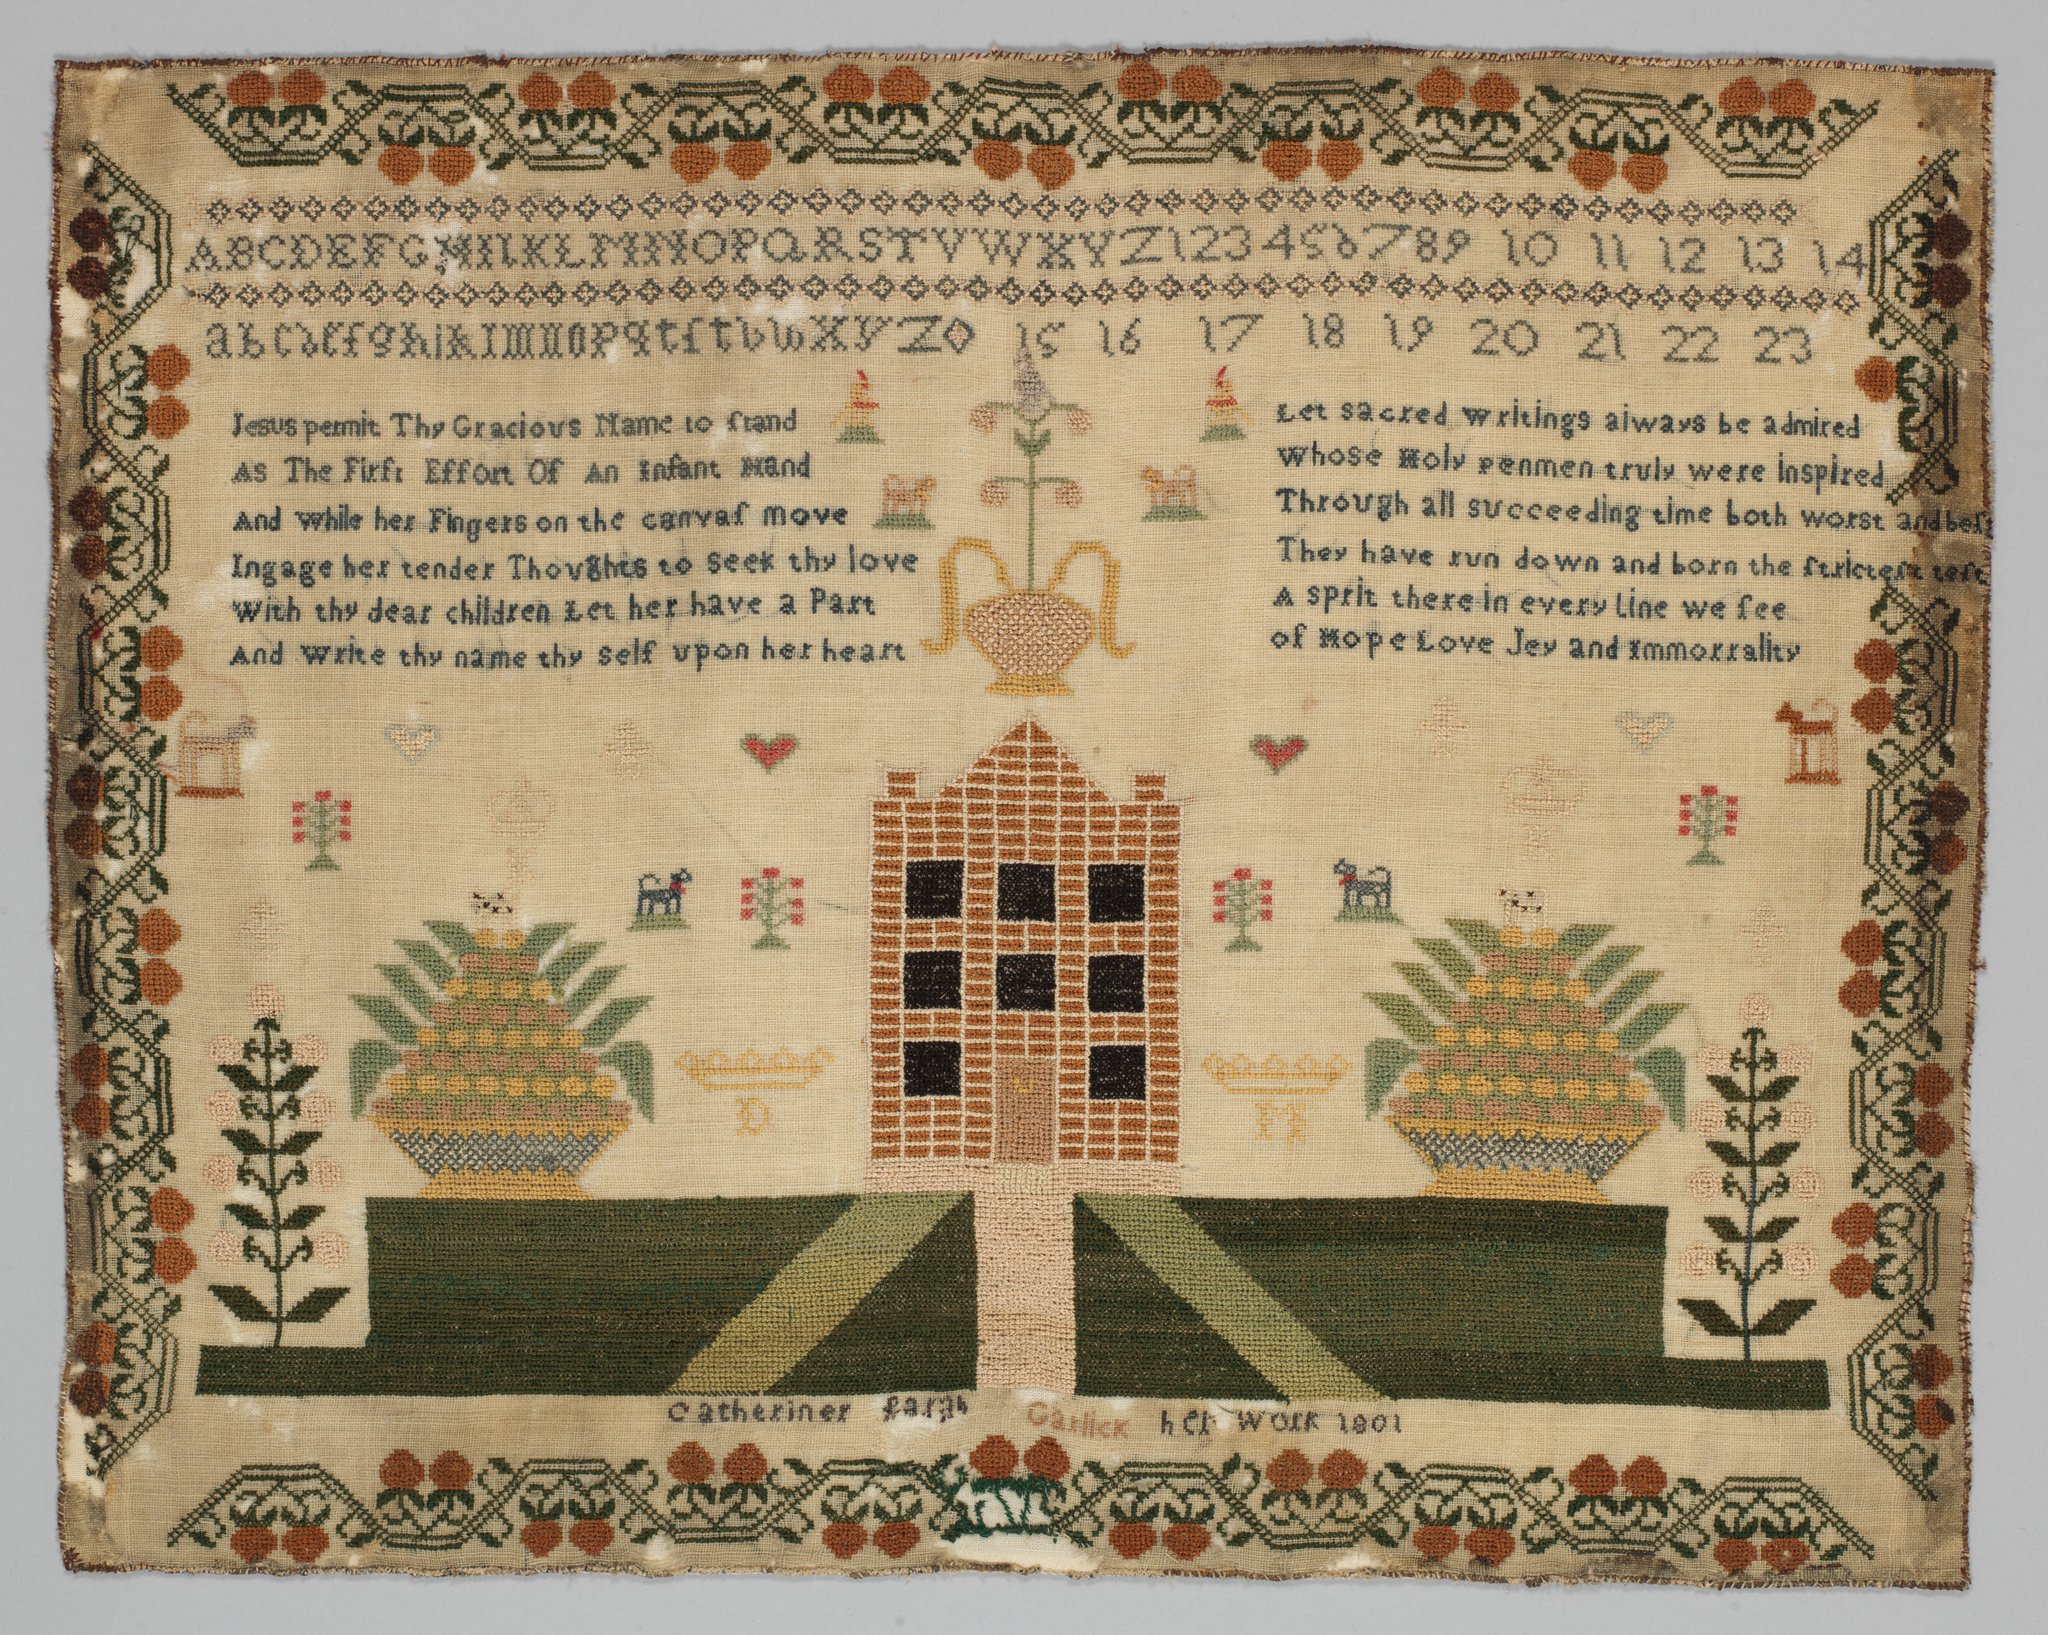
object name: sampler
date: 1801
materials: canvas, silk, wool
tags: houses,flowers